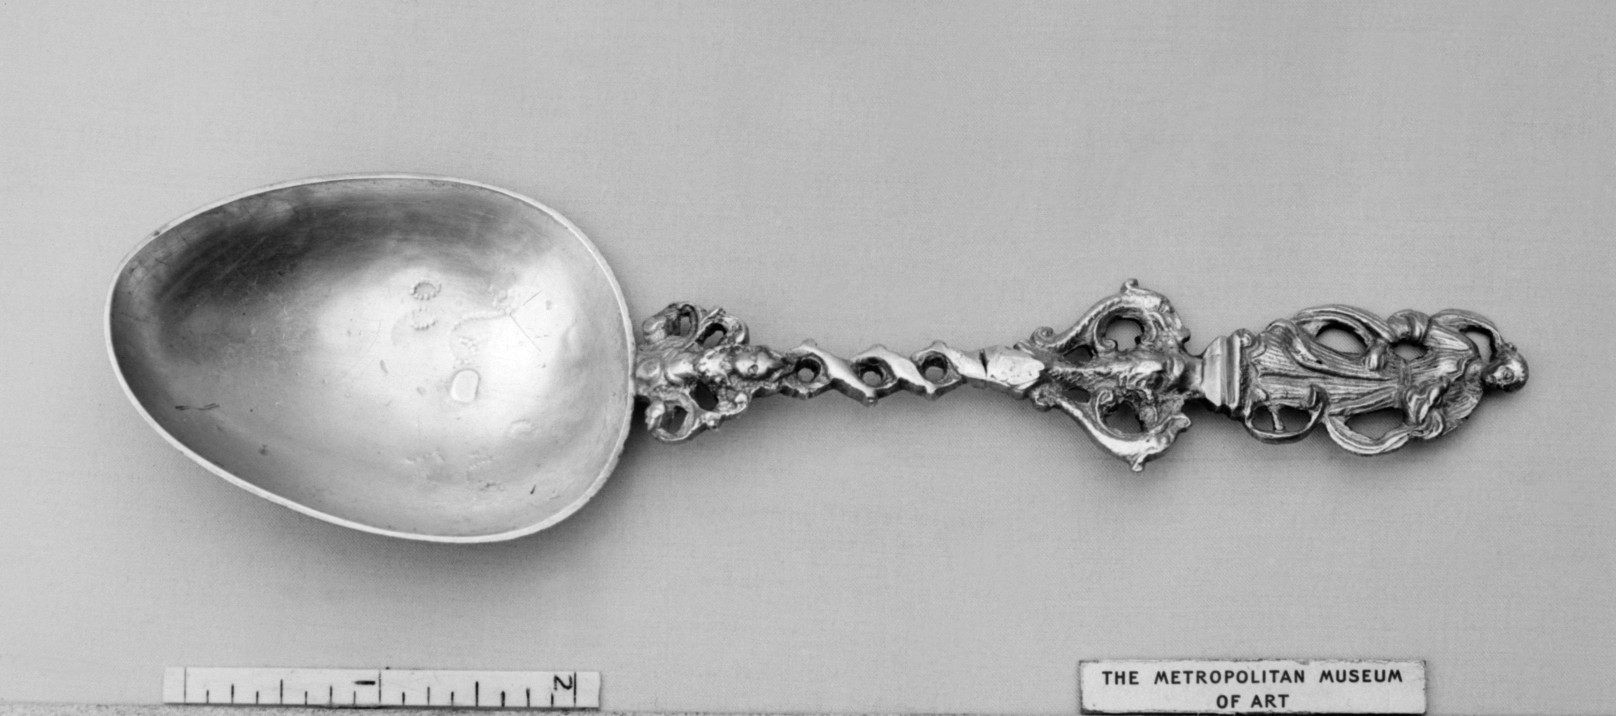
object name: spoon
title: Figure-top spoon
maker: y. posthumus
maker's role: maker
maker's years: 1794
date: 1790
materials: silver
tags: men